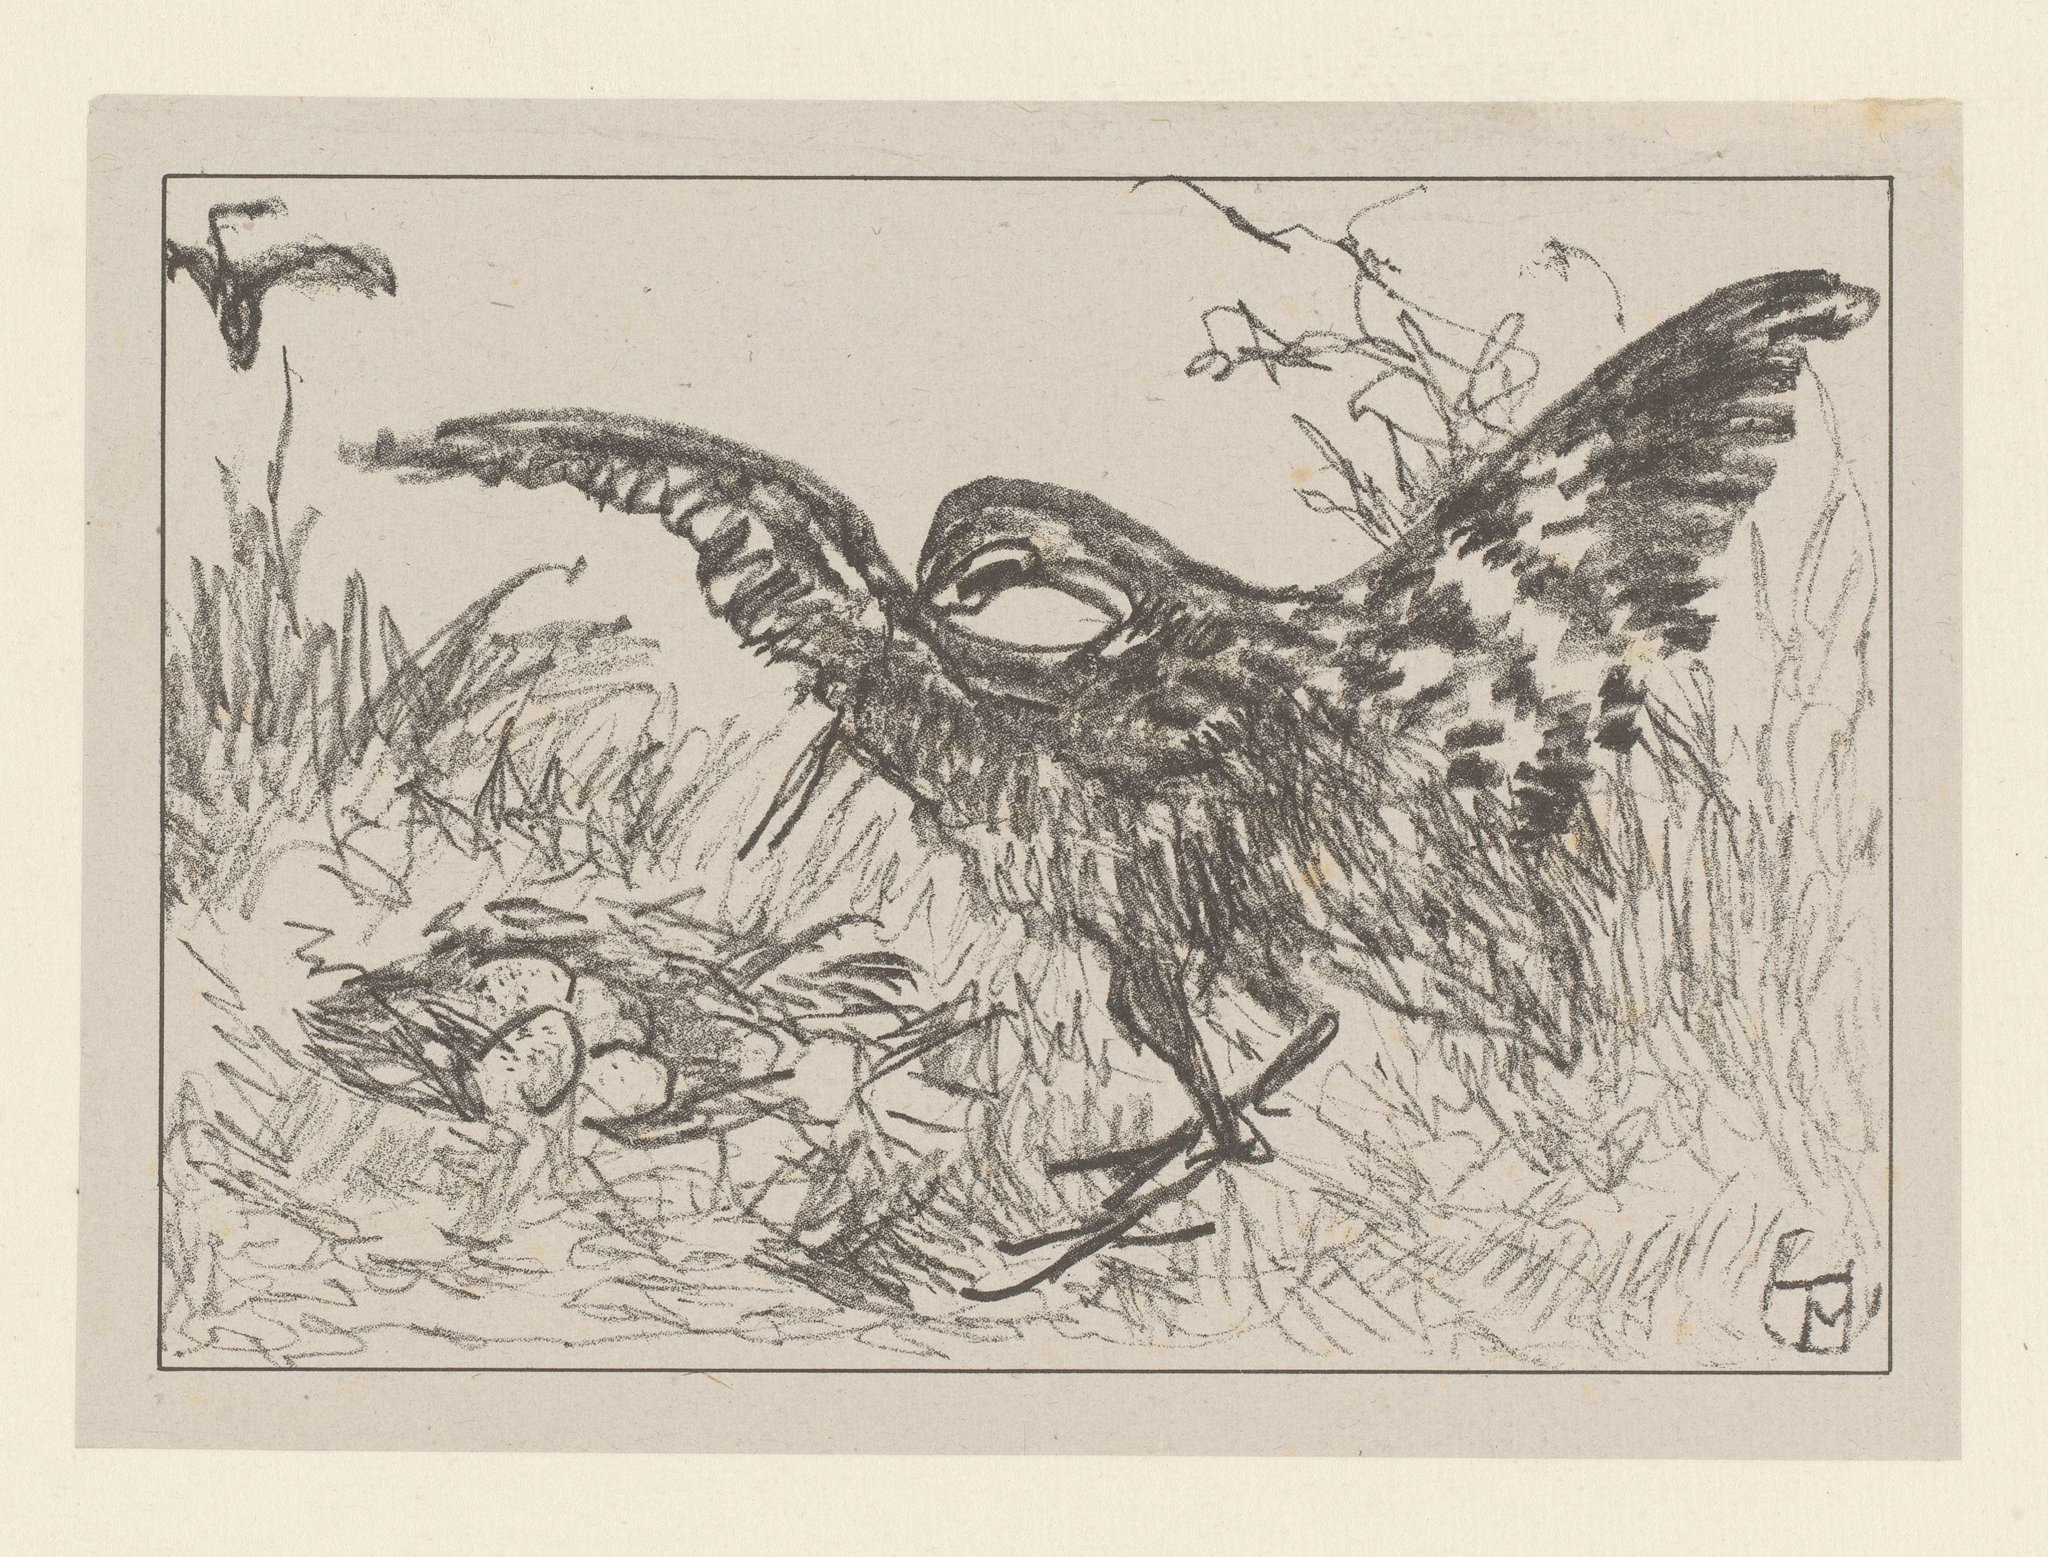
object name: print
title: Tureluur bij nest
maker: theo van hoytema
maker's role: draughtsman, painter, print maker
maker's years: 1863-1917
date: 1878-1917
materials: paper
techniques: lithograph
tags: shore-birds and wading-birds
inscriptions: collector's mark: Lugt 4731, collector's mark: Lugt 2228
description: Prent is een proefdruk voor kalenderblad april 1918.